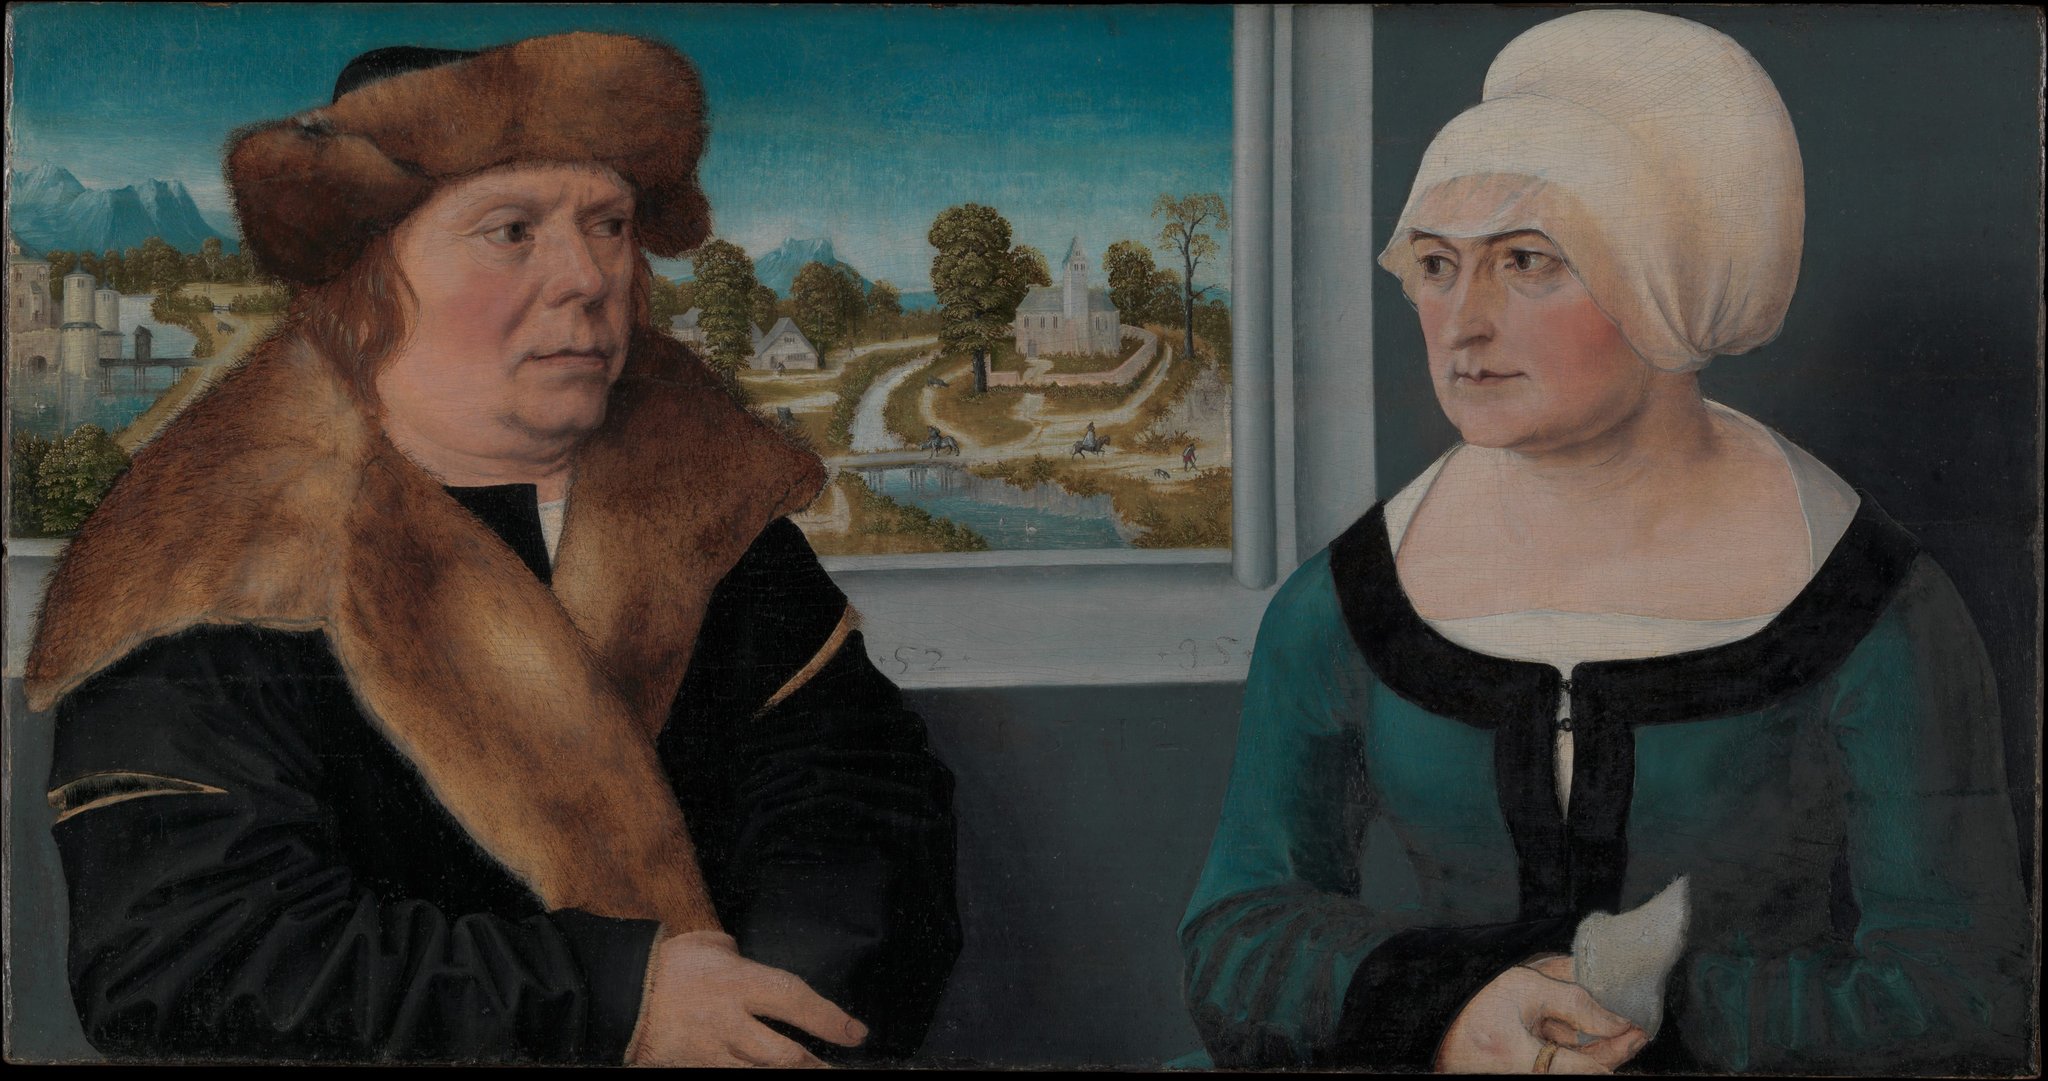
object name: painting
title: Portrait of a Married Couple (Lorenz Kraffter and Honesta Merz?)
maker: ulrich apt the elder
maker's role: artist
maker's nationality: german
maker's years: 1460-1532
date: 1512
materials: wood, oil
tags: couples,men,portraits,women